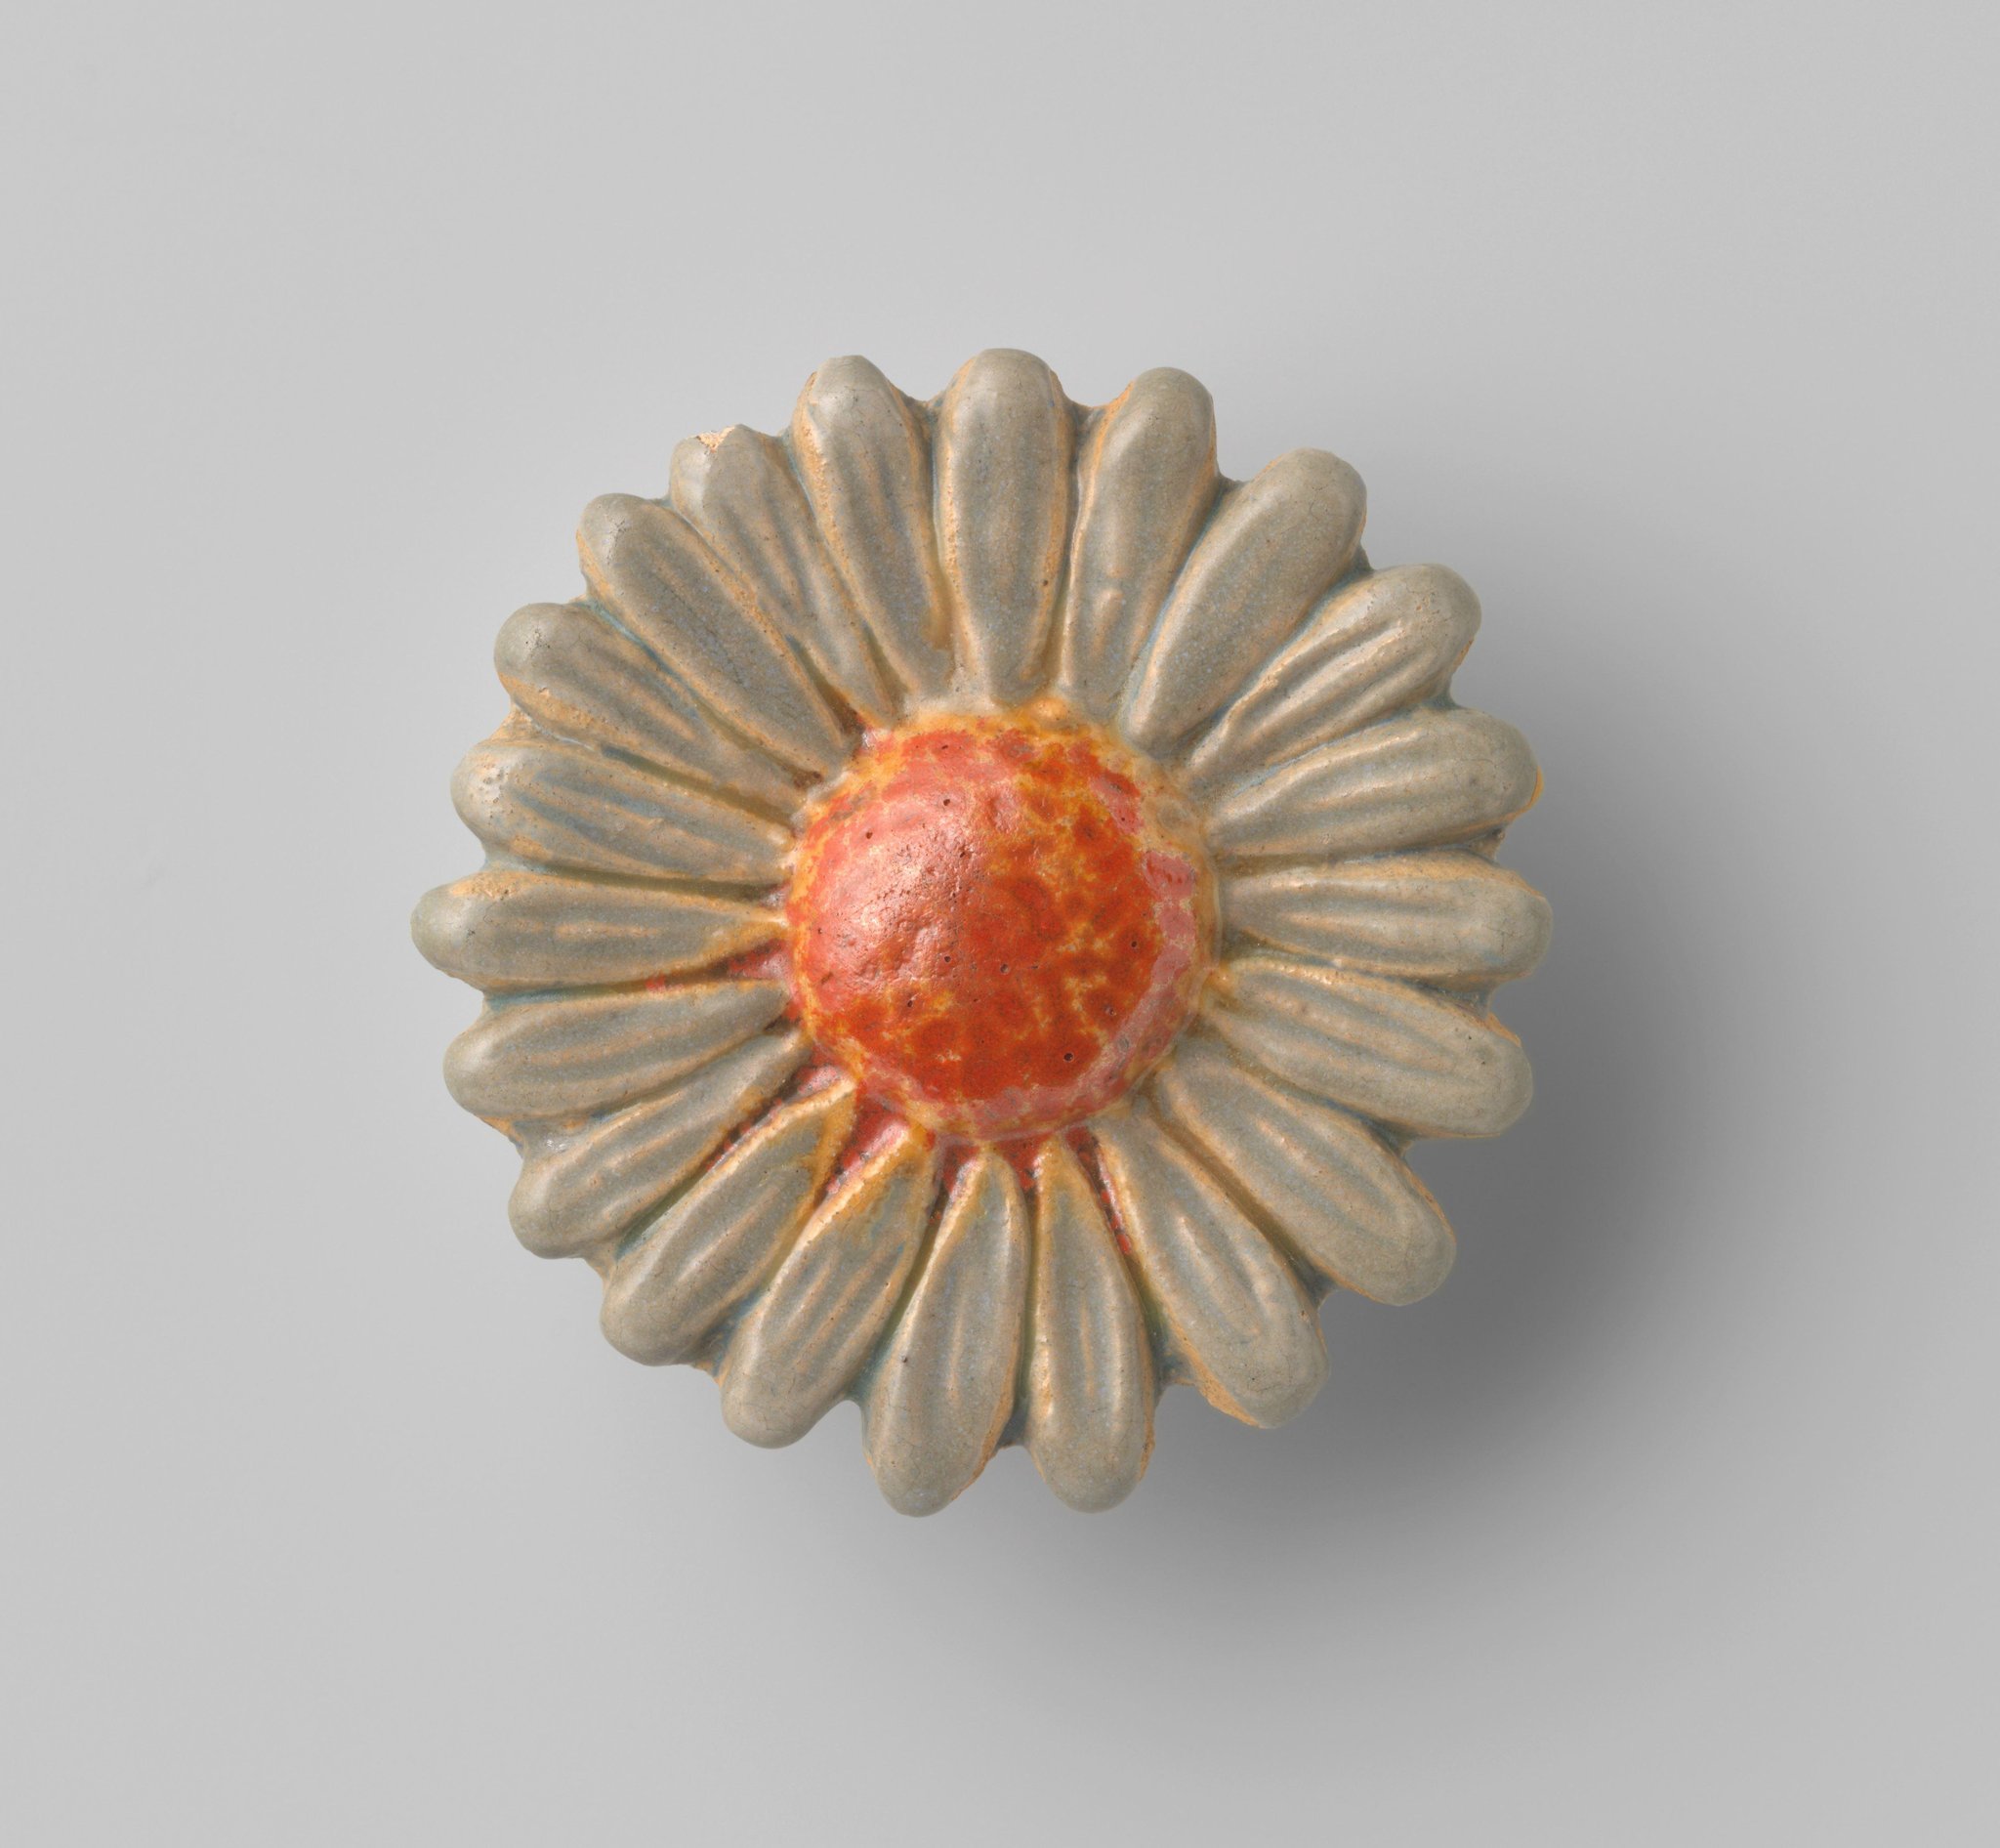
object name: brooch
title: Two brooches in the form of a daisy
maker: Anonymous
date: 1943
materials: ceramic, metal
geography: europe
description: Silent Resistance –War and Liberation Jewellery During the Second World War, small pieces of jewellery were worn in the Netherlands as a silent protest against the German occupier. In April 1941, Dutch coins were officially confiscated for the war industry. As jewellery did not have to be surrendered, coins were quickly transformed into rings, brooches, pins and bracelets. A portrait of Queen Wilhelmina was worn as a sign of resistance, as well as a token of loyalty to the royal family. Margriet Francisca, the third daughter of Princess Juliana and Prince Bernard, was born in Canada in January 1943. The pin with the three yellow chicks refers to the three young princesses Beatrix, Irene and Margriet and the steadfastness of the Dutch royal family. After the liberation, coins and silver were used for jewellery conveying messages of hope for a peaceful future.